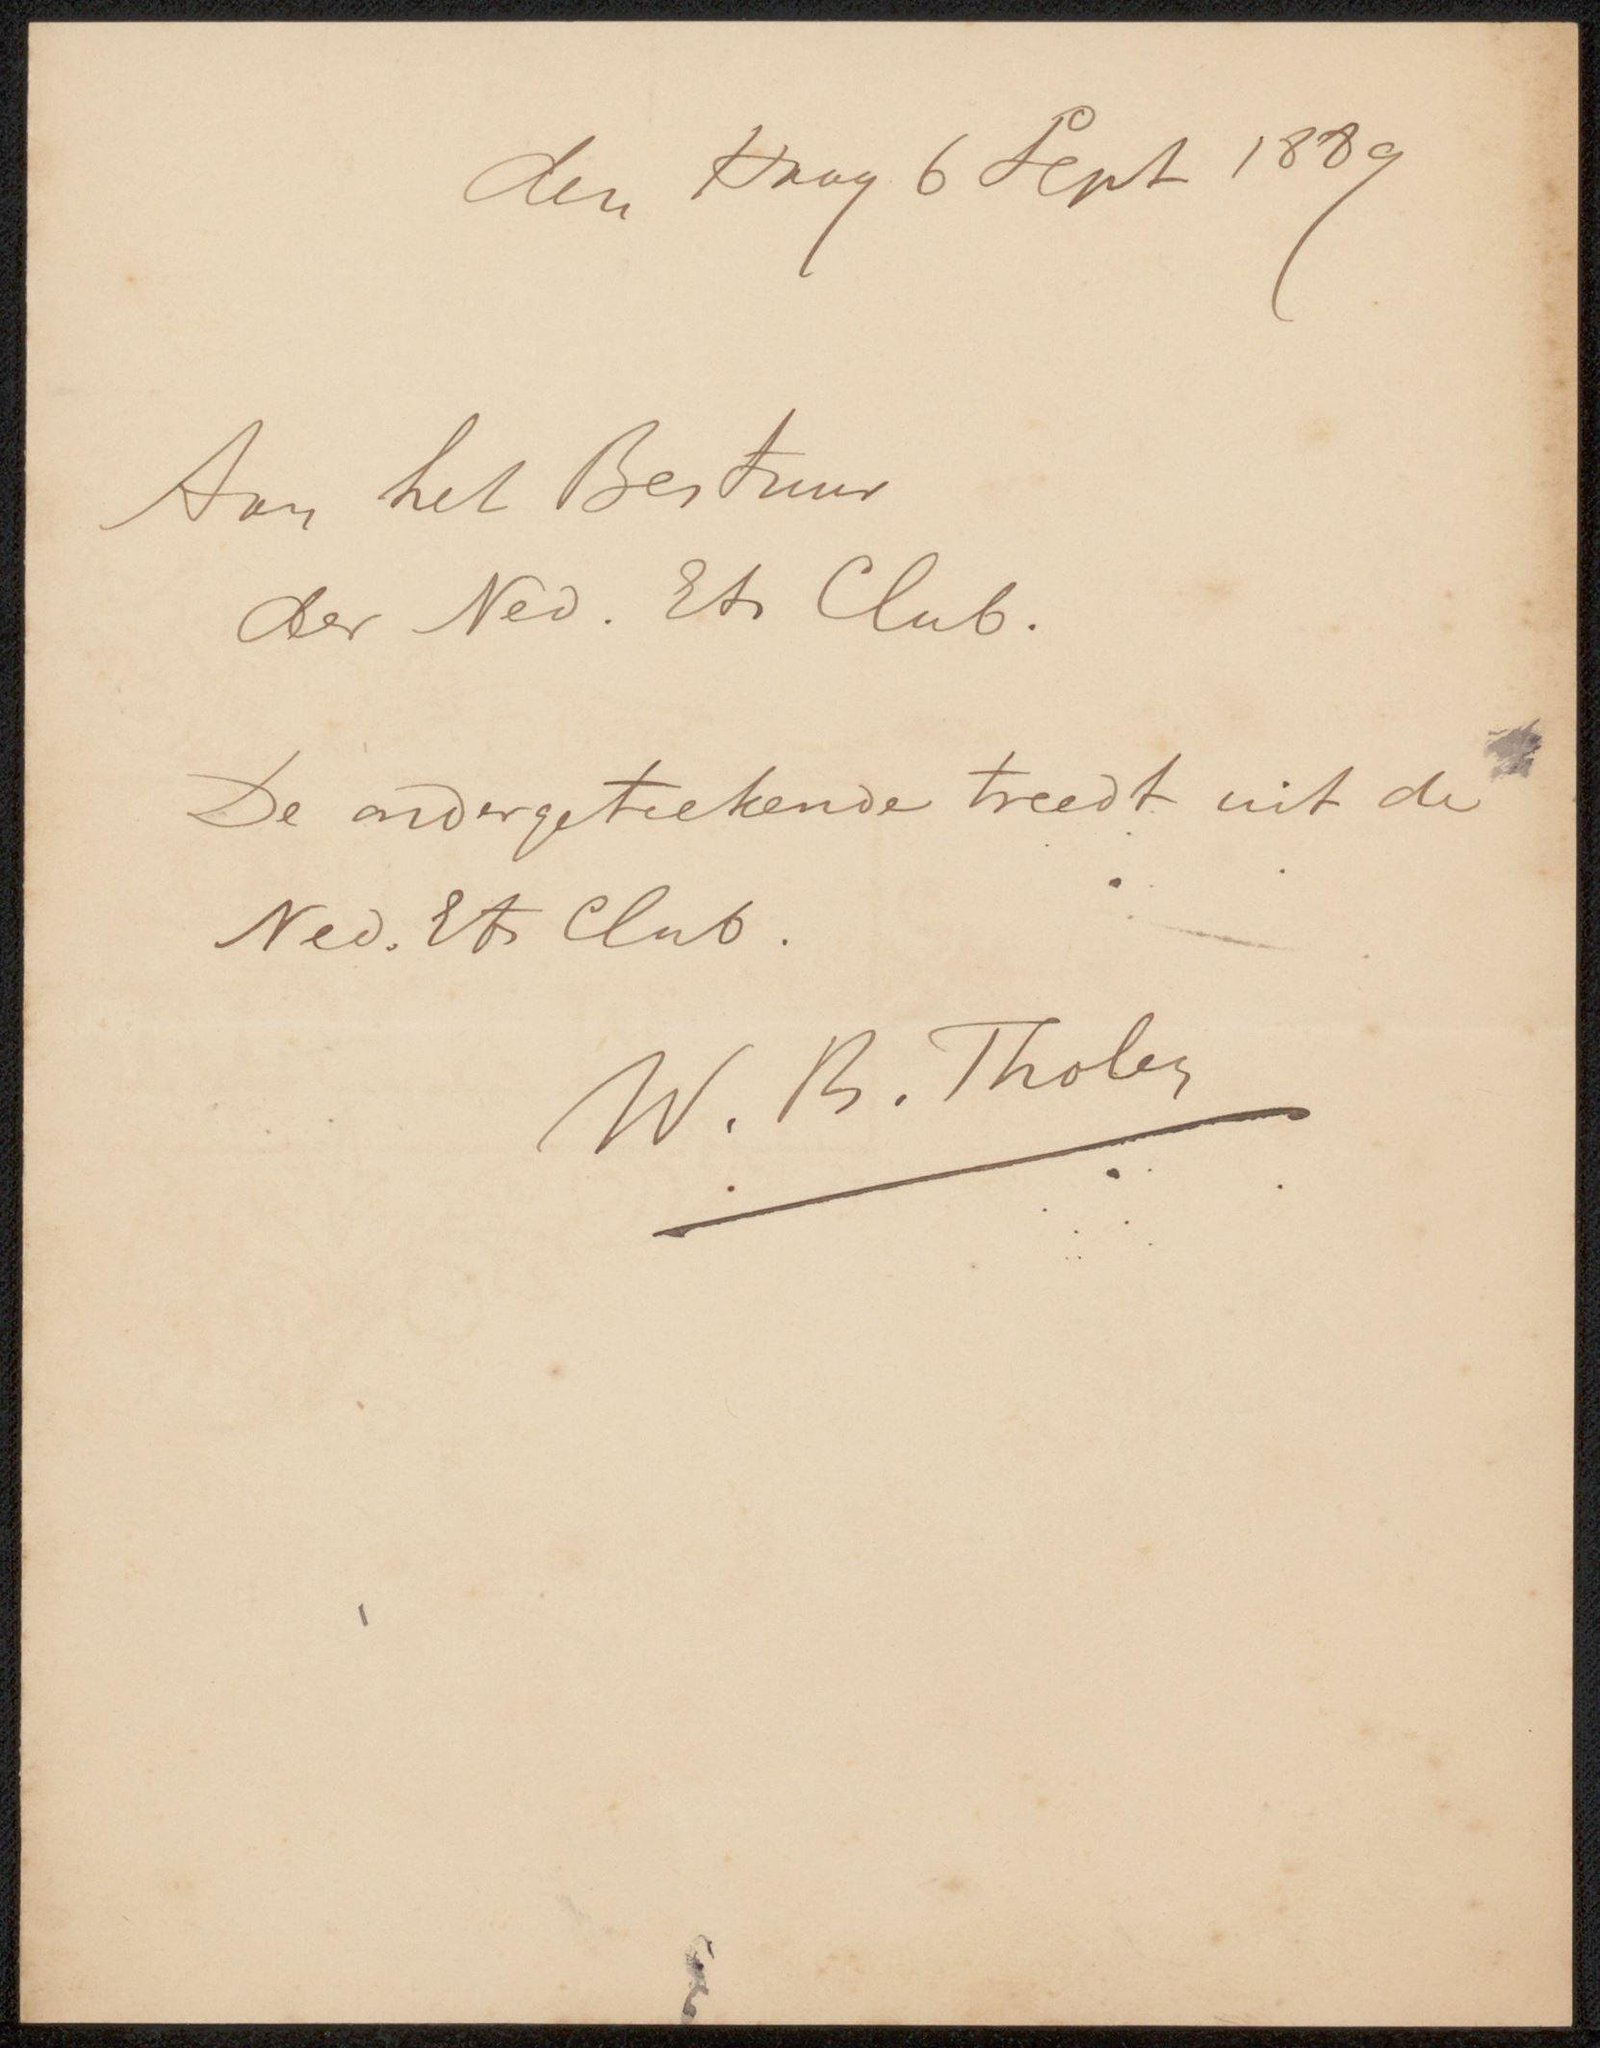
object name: letter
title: Brief aan het Bestuur van de Nederlandse Etsclub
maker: willem bastiaan tholen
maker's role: draughtsman, painter, print maker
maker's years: 1860-1931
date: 1889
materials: ink, paper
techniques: pen, writing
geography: the hague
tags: nederlandsche etsclub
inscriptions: watermark, collector's mark: ‘RPK’